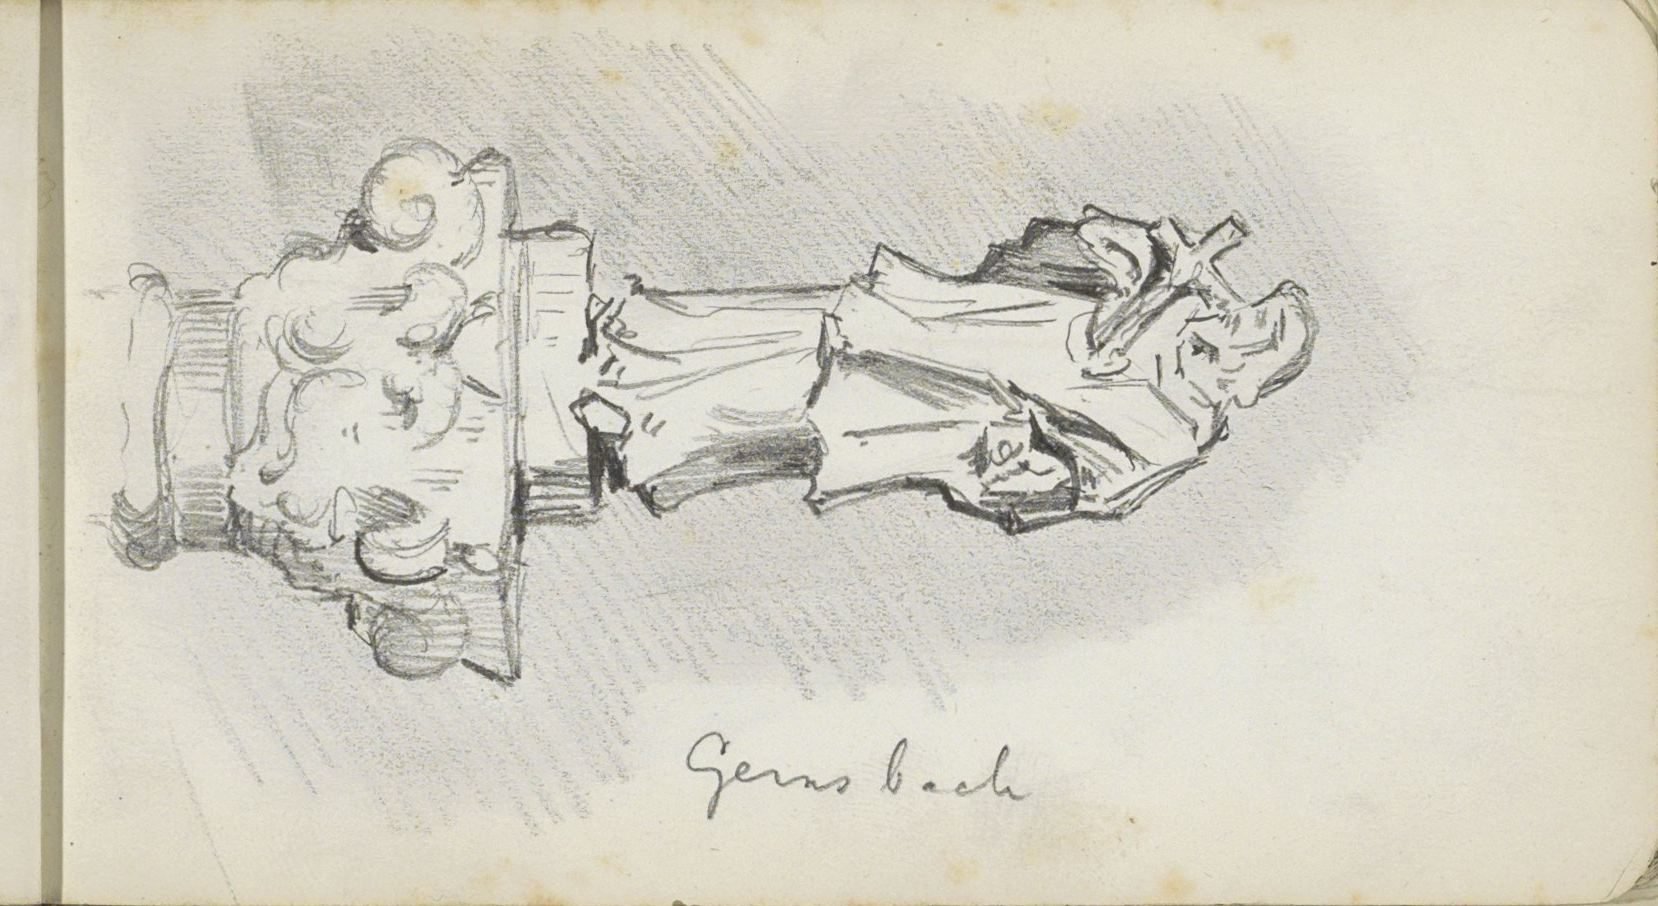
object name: sketchbook leaf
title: Heiligenbeeld aan de gevel van het Rathaus te Gernsbach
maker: geo poggenbeek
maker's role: draughtsman, painter, print maker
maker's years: 1853-1903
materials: paper, pencil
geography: gernsbach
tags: saints, piece of sculpture, reproduction of a piece of sculpture, capital (~ column, pillar)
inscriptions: annotation: ‘Gernsbach’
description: Blad 36 recto uit een schetsboek met 69 bladen.